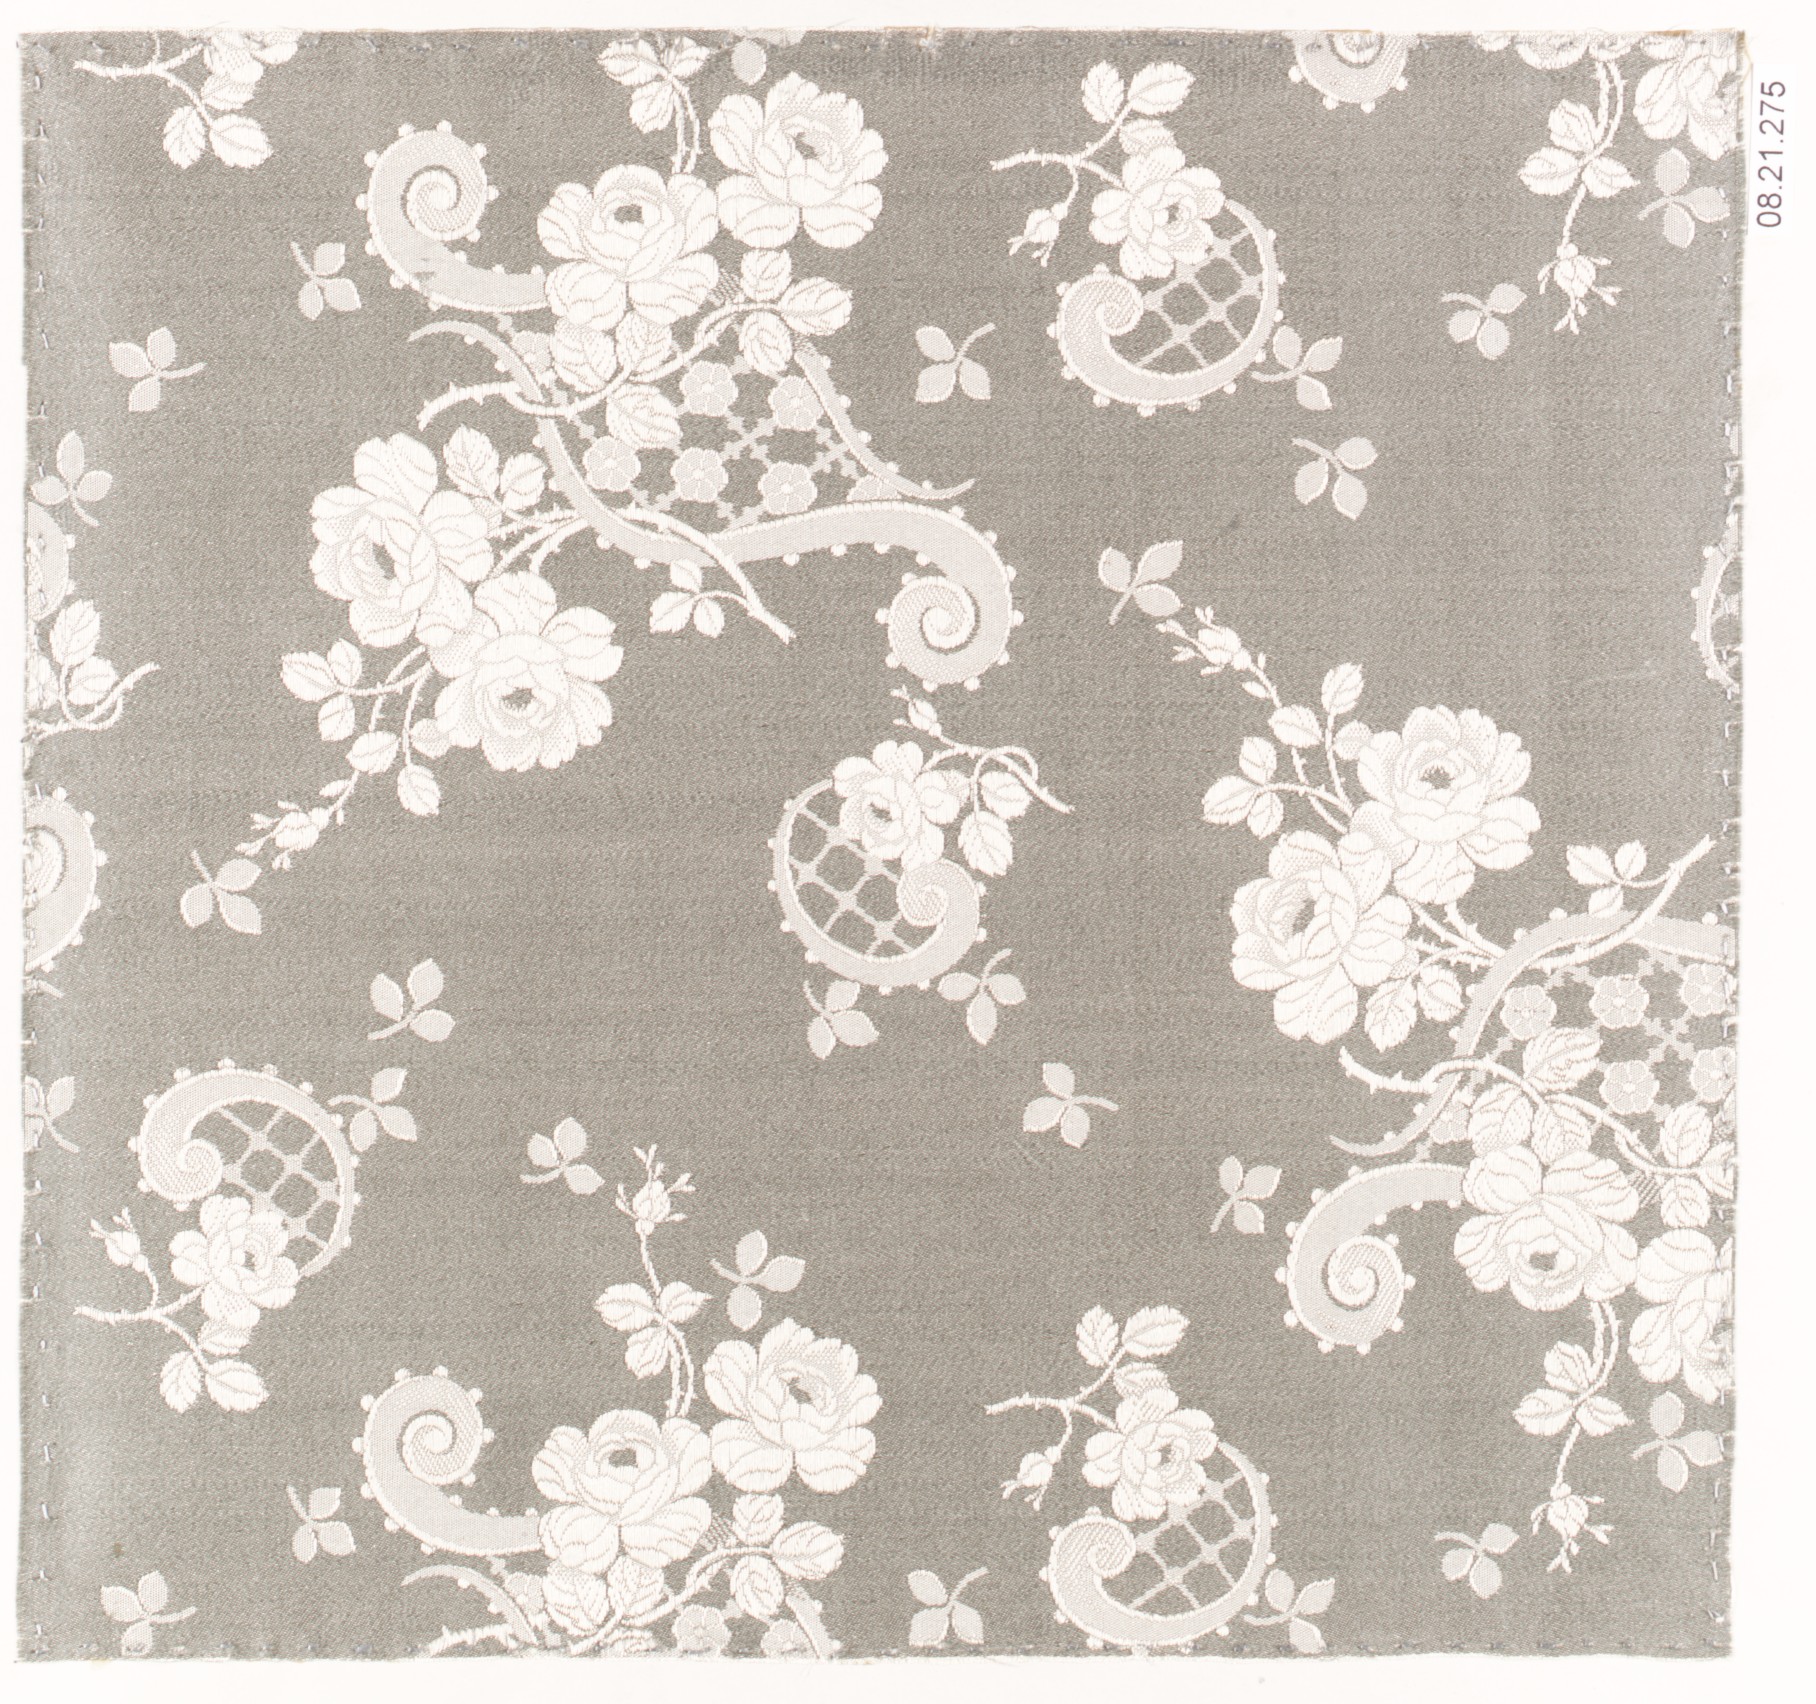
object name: textile sample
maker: Anonymous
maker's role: designer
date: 1900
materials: silk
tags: roses